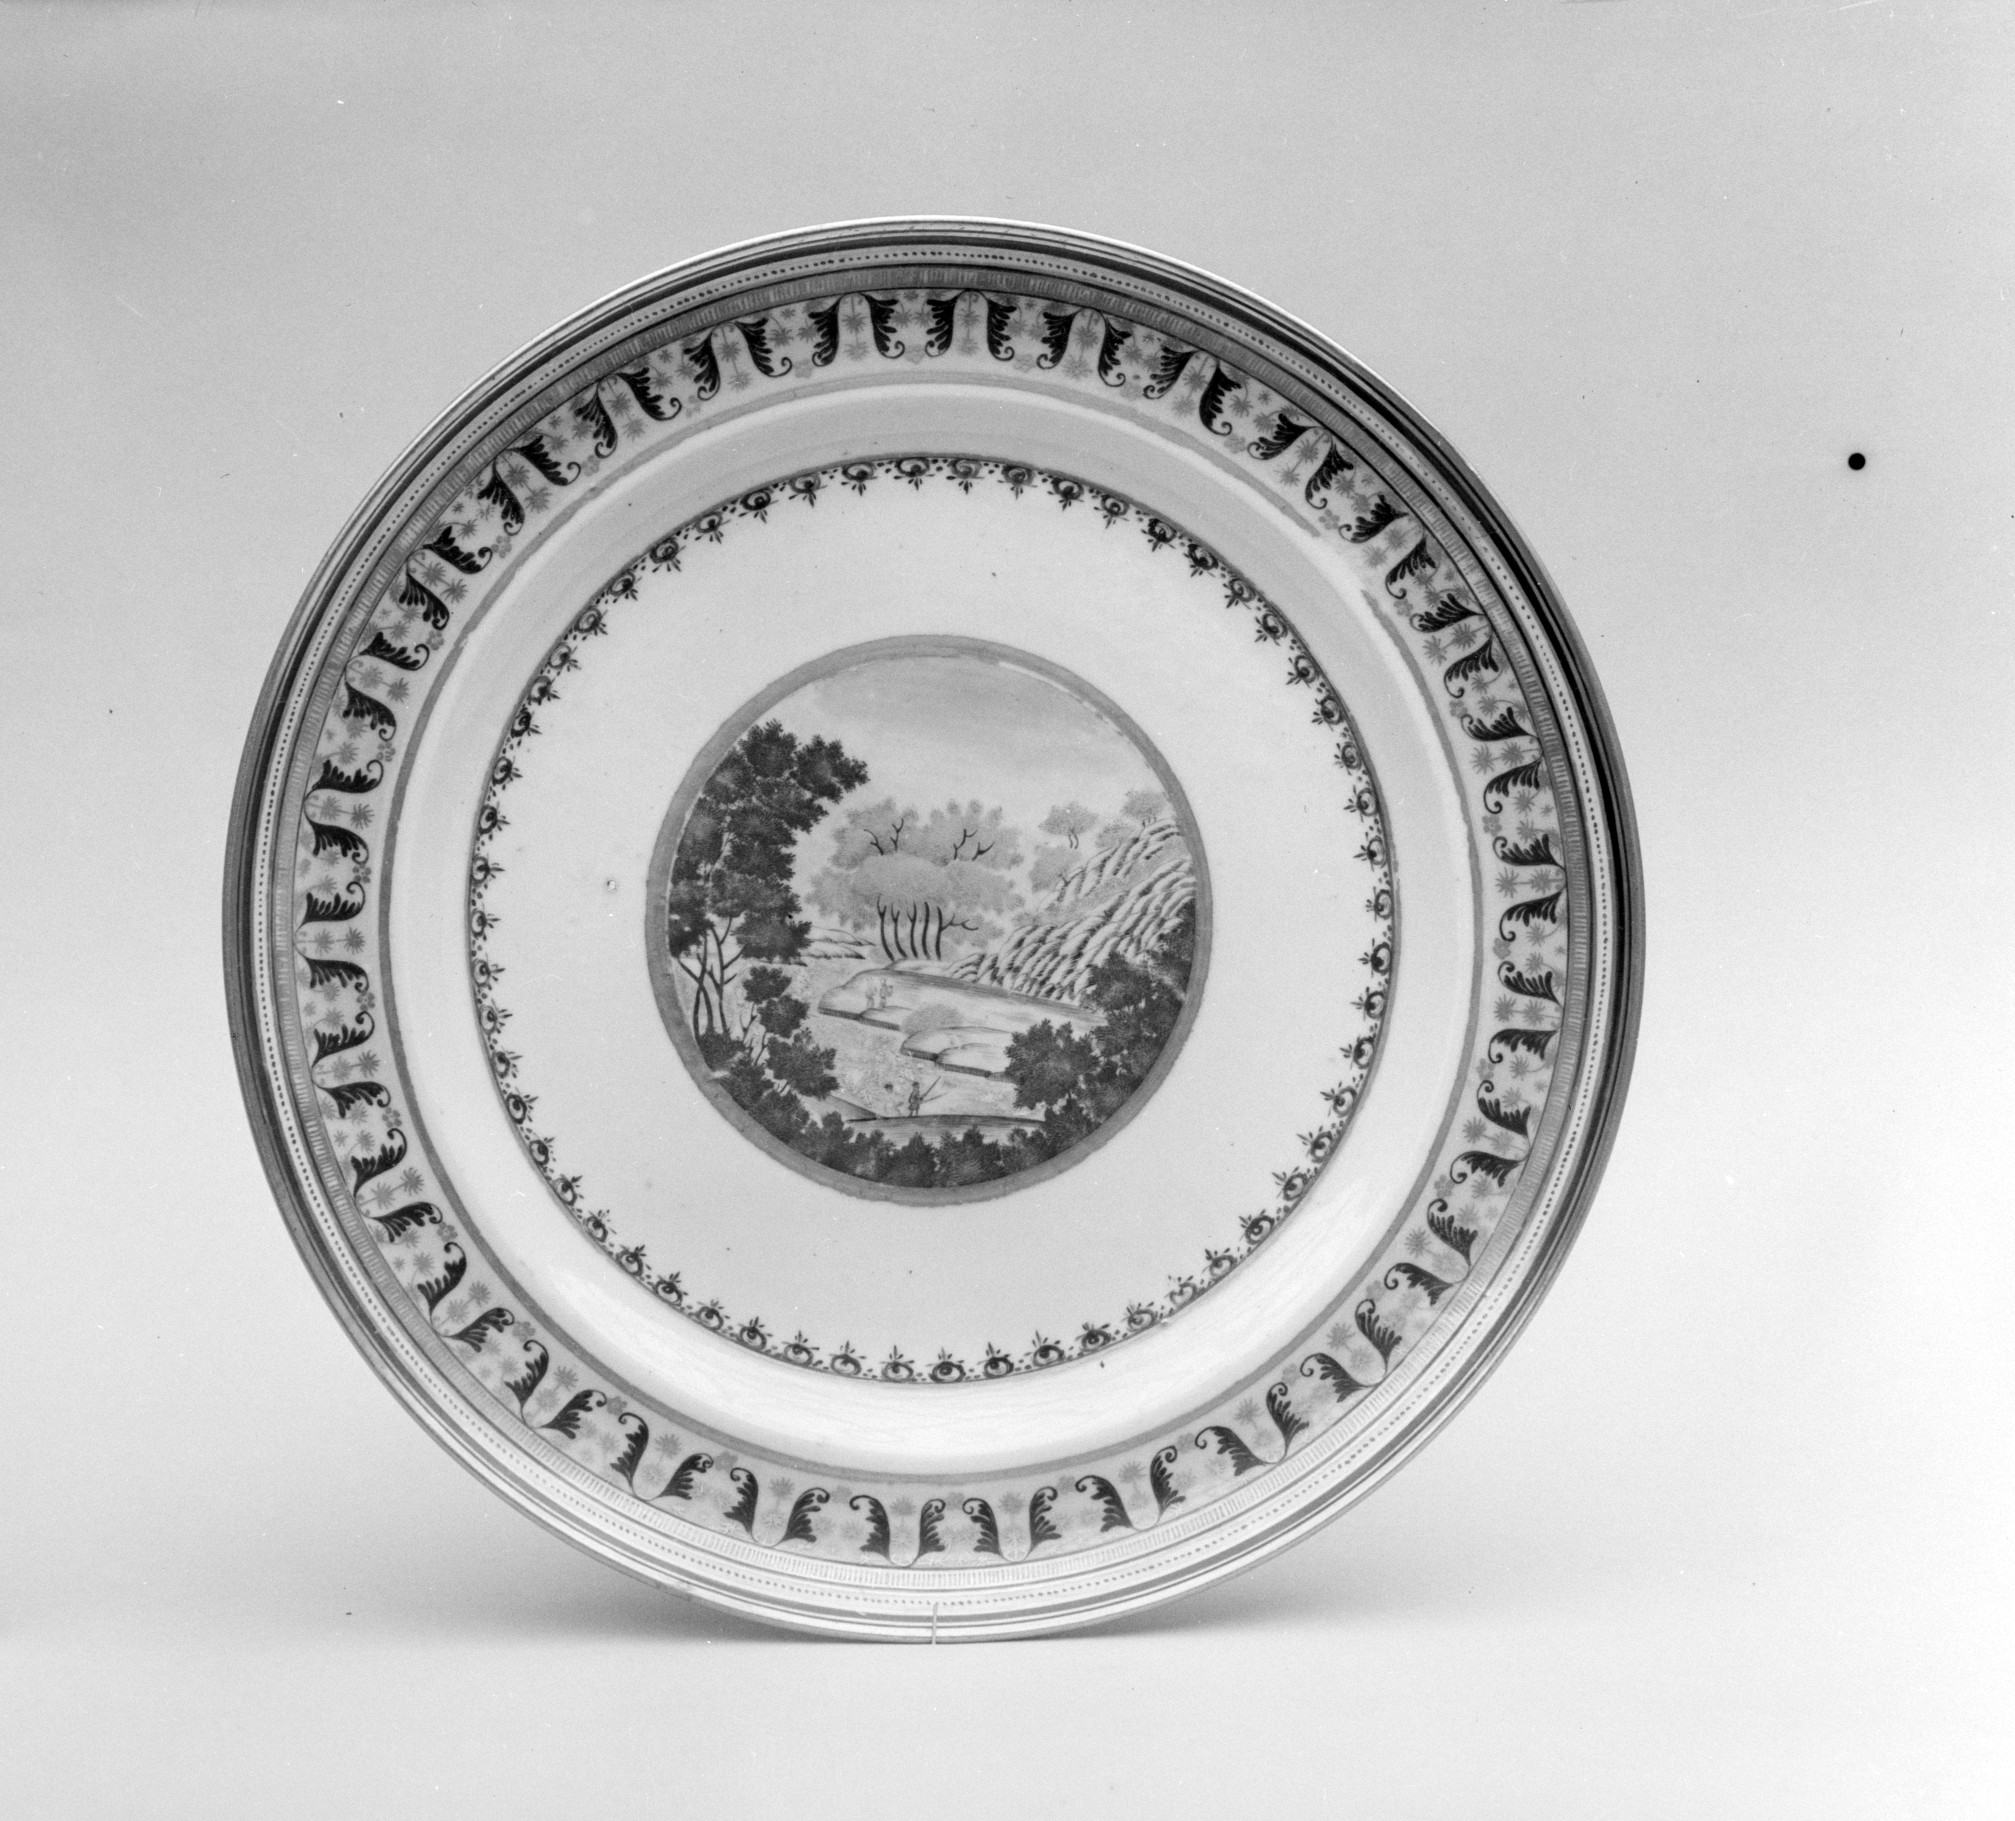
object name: plate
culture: chinese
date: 1800-1830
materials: porcelain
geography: china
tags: landscapes